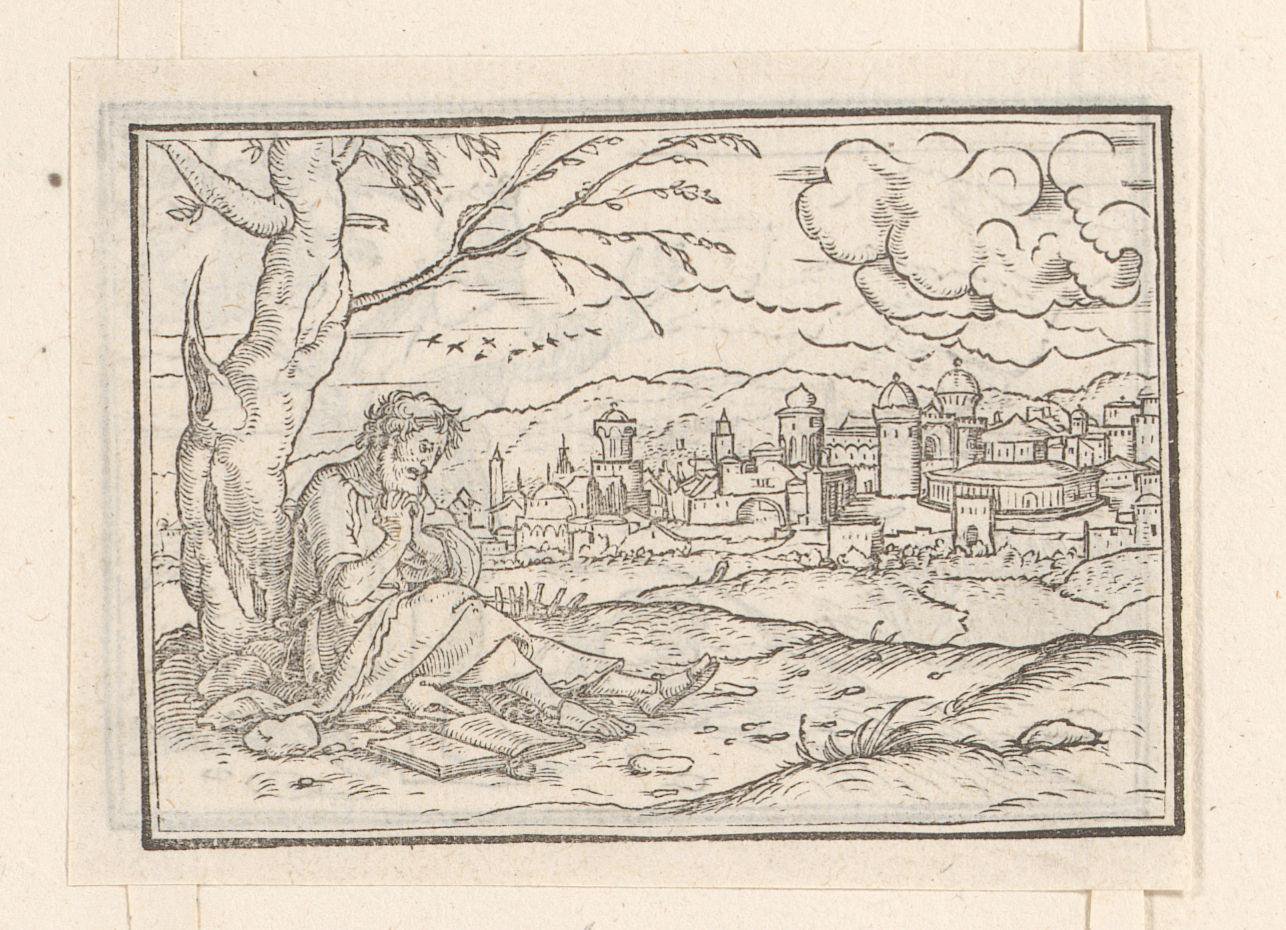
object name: album leaf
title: Jona zit onder de wonderboom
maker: veit rudolf specklin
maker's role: print maker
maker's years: -1550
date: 1538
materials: paper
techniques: woodcut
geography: switzerland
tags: the prophet jonah withdraws from nineveh; he builds a booth and while enjoying the shade of a plant (gourd or vine) which god made grow for him, he awaits the destiny of the city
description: Jona zit met uitzicht op de stad Nineve te wachten tot God de stad zal vernietigen. God heeft een wonderboom voor hem laten groeien, zodat hij in de schaduw kan zitten. Maar de volgende dag is de boom verdord, de bladeren hangen slap, en Jona wordt bevangen door de hitte. Prent maakt deel uit van een album.